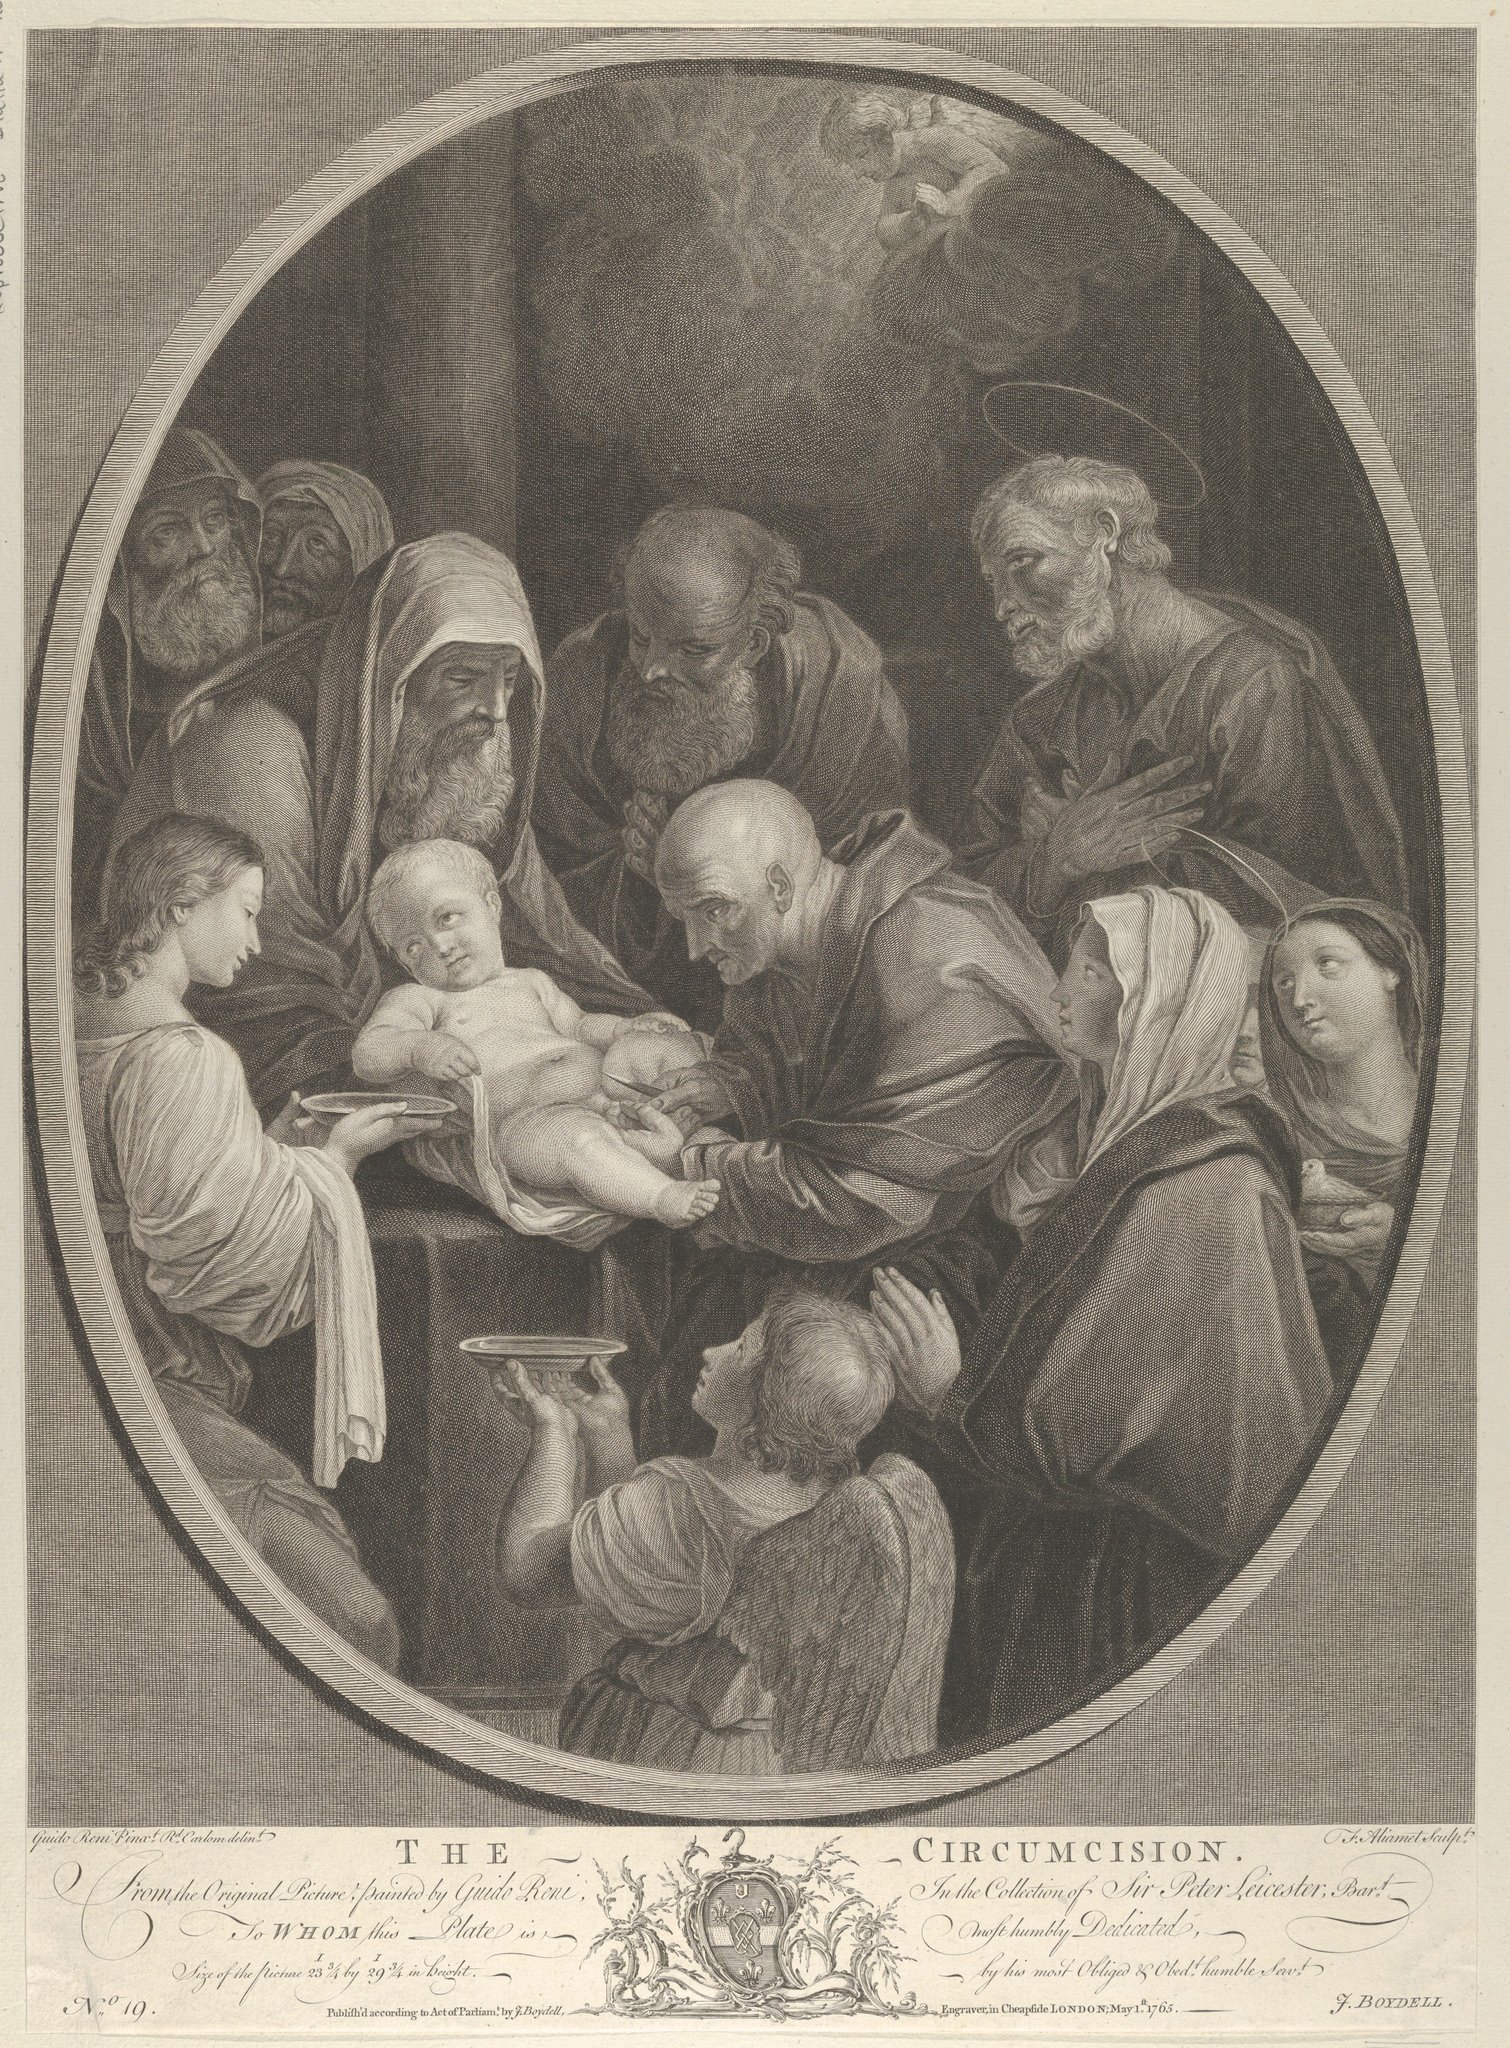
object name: print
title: The Circumcision of Christ, a group of men and women surrounding him, an angel in the foreground, after Reni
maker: françois germain aliamet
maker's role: engraver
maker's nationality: french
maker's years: 1734-1790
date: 1765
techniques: engraving, etching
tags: men,women,angels,jesus,circumcision